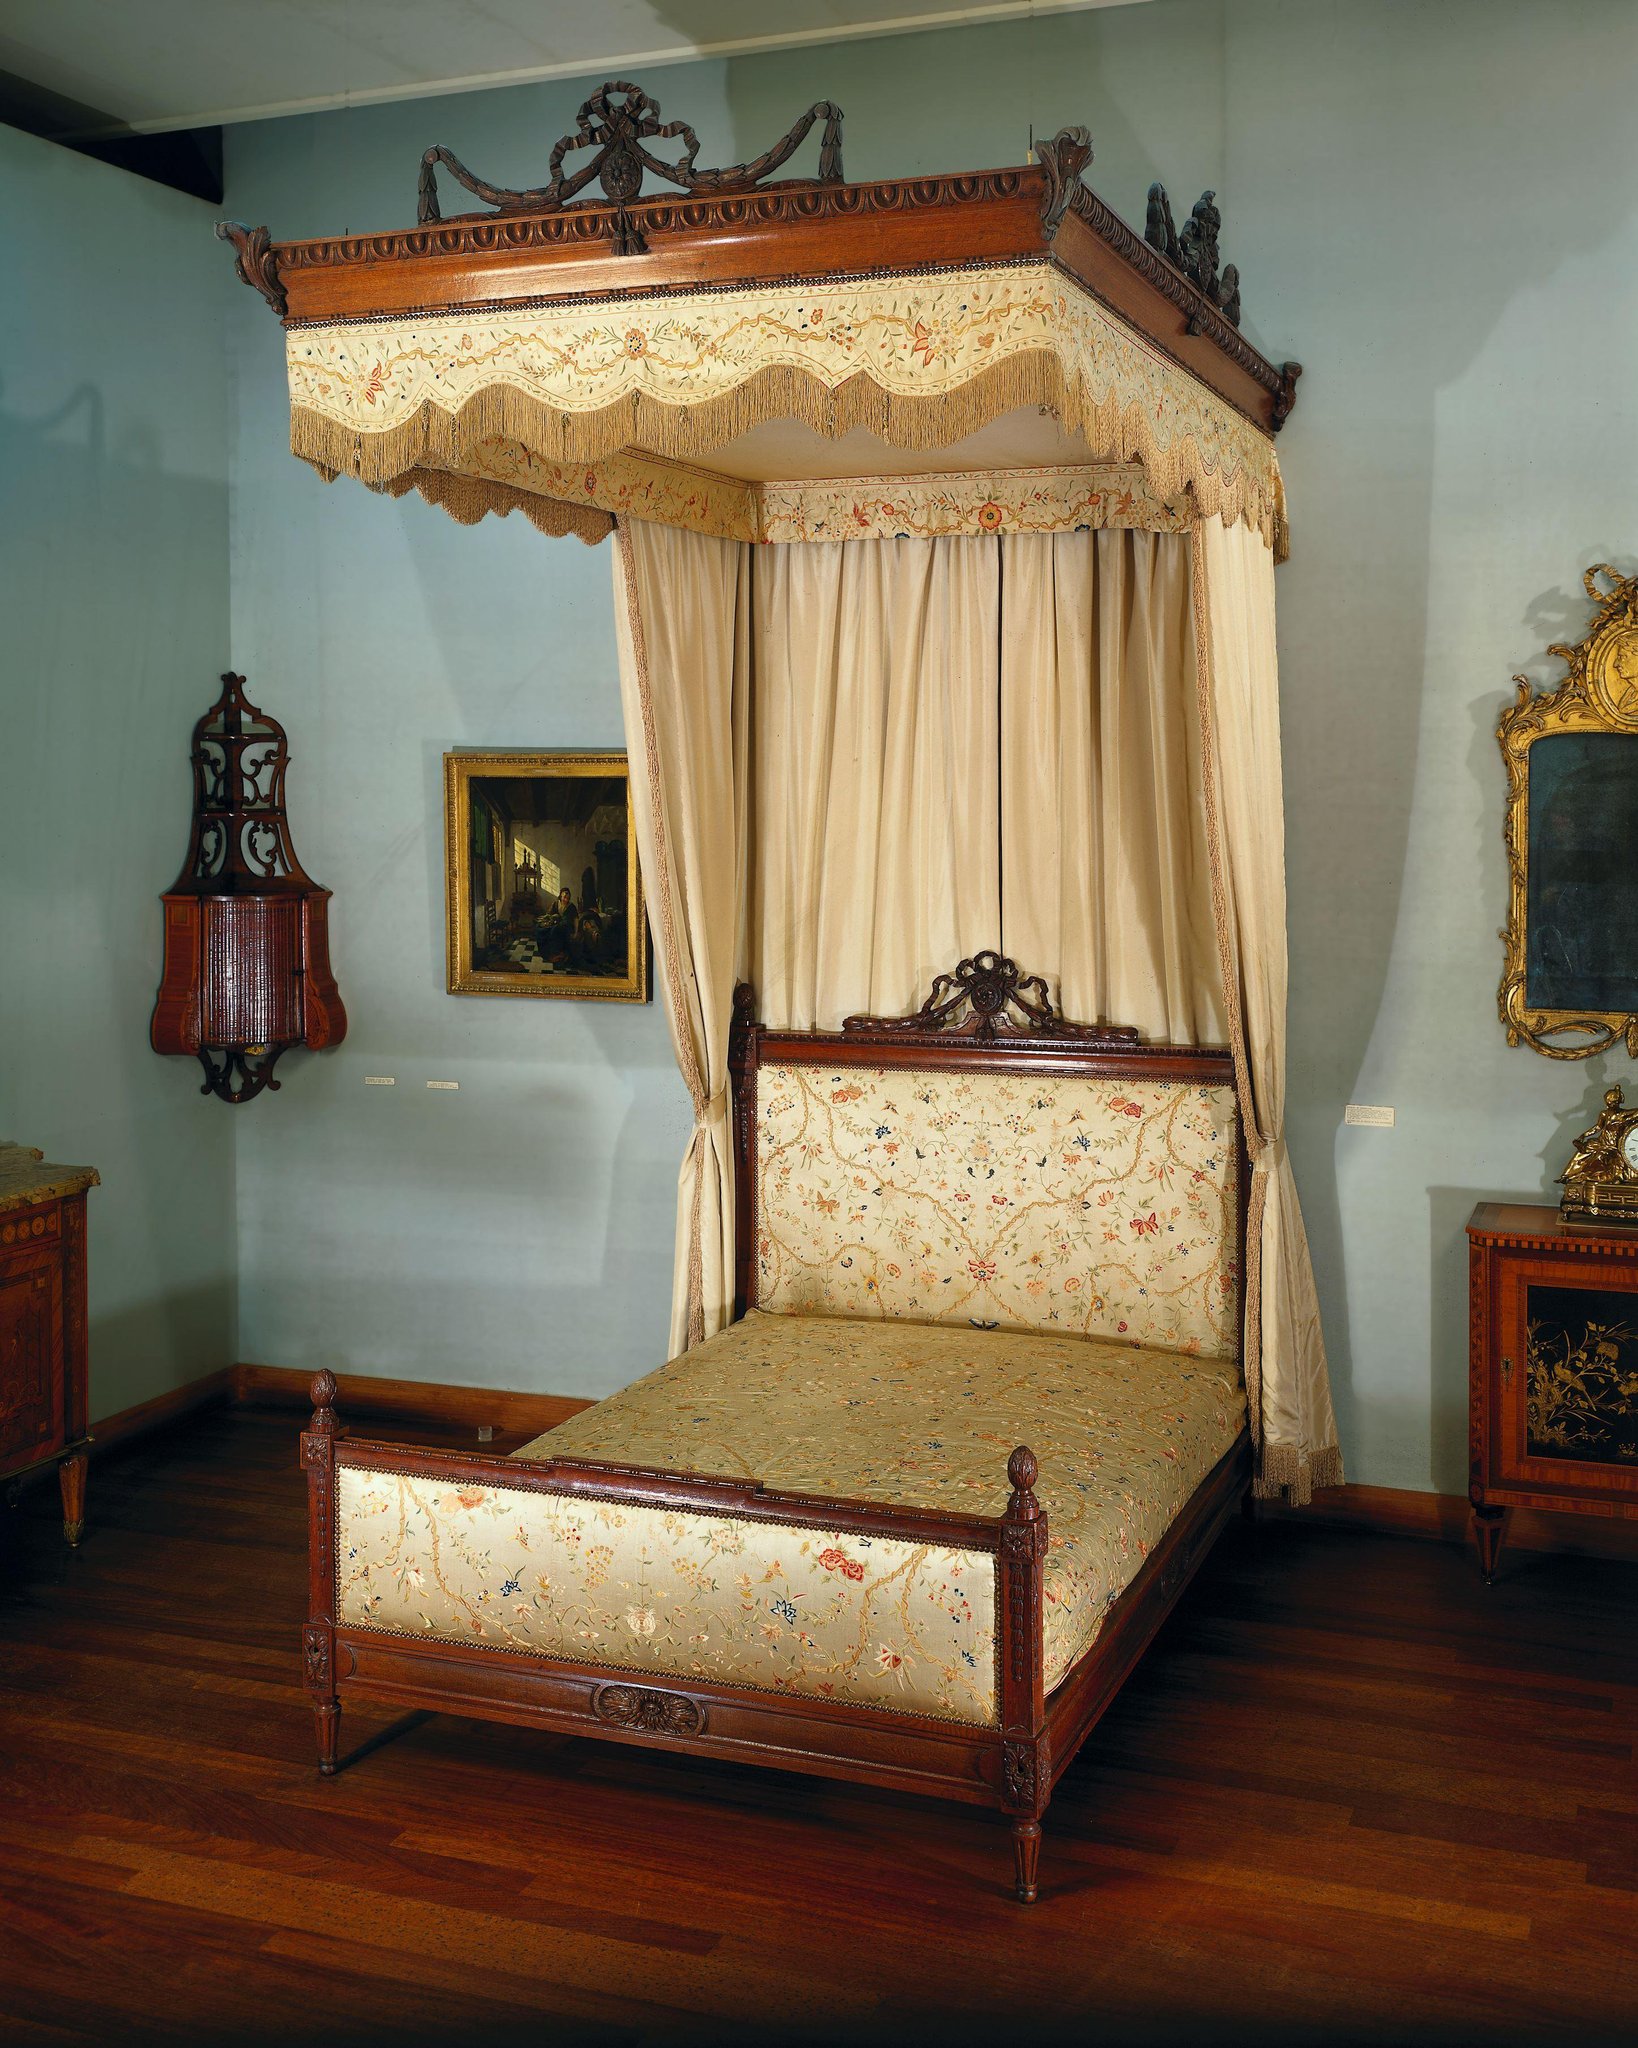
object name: fragment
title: Strook, recht, van crème-witte satijn, kleurig geborduurd met een rozet in het midden waarvan aan beide kanten een golvende bloemenrank uitgaat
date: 1750-1800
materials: silk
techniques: embroidered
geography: china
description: Strook, recht, van crème-witte satijn, kleurig geborduurd met een rozet in het midden waarvan aan beide kanten een golvende bloemenrank uitgaat. Chinese zijde.